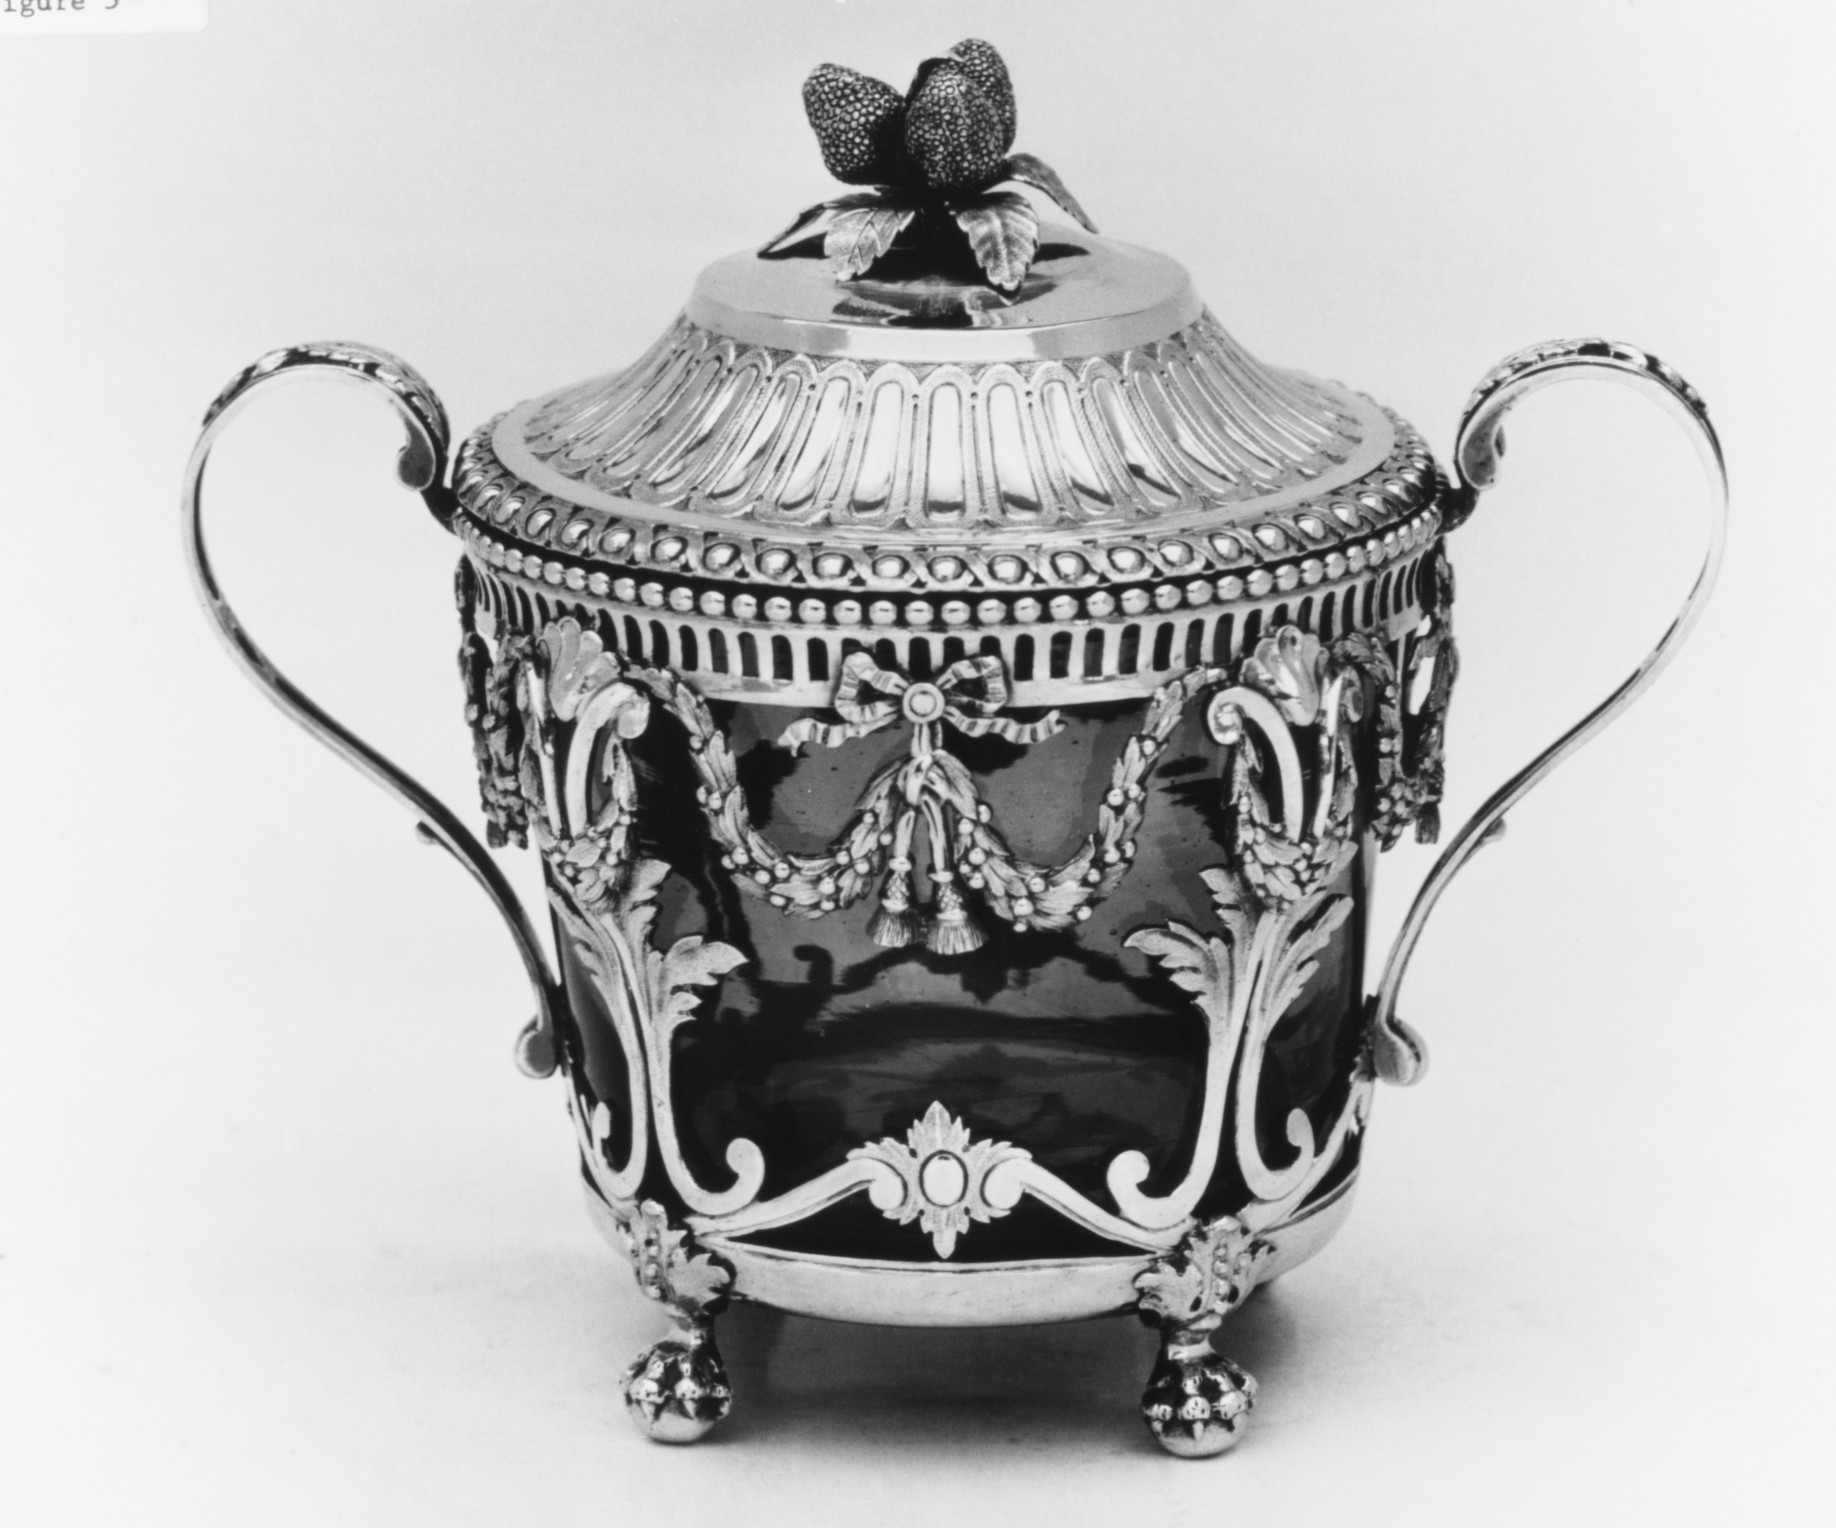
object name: sugar bowl with cover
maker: jacques favre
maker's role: maker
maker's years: 1744-1823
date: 1779-1780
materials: glass, silver